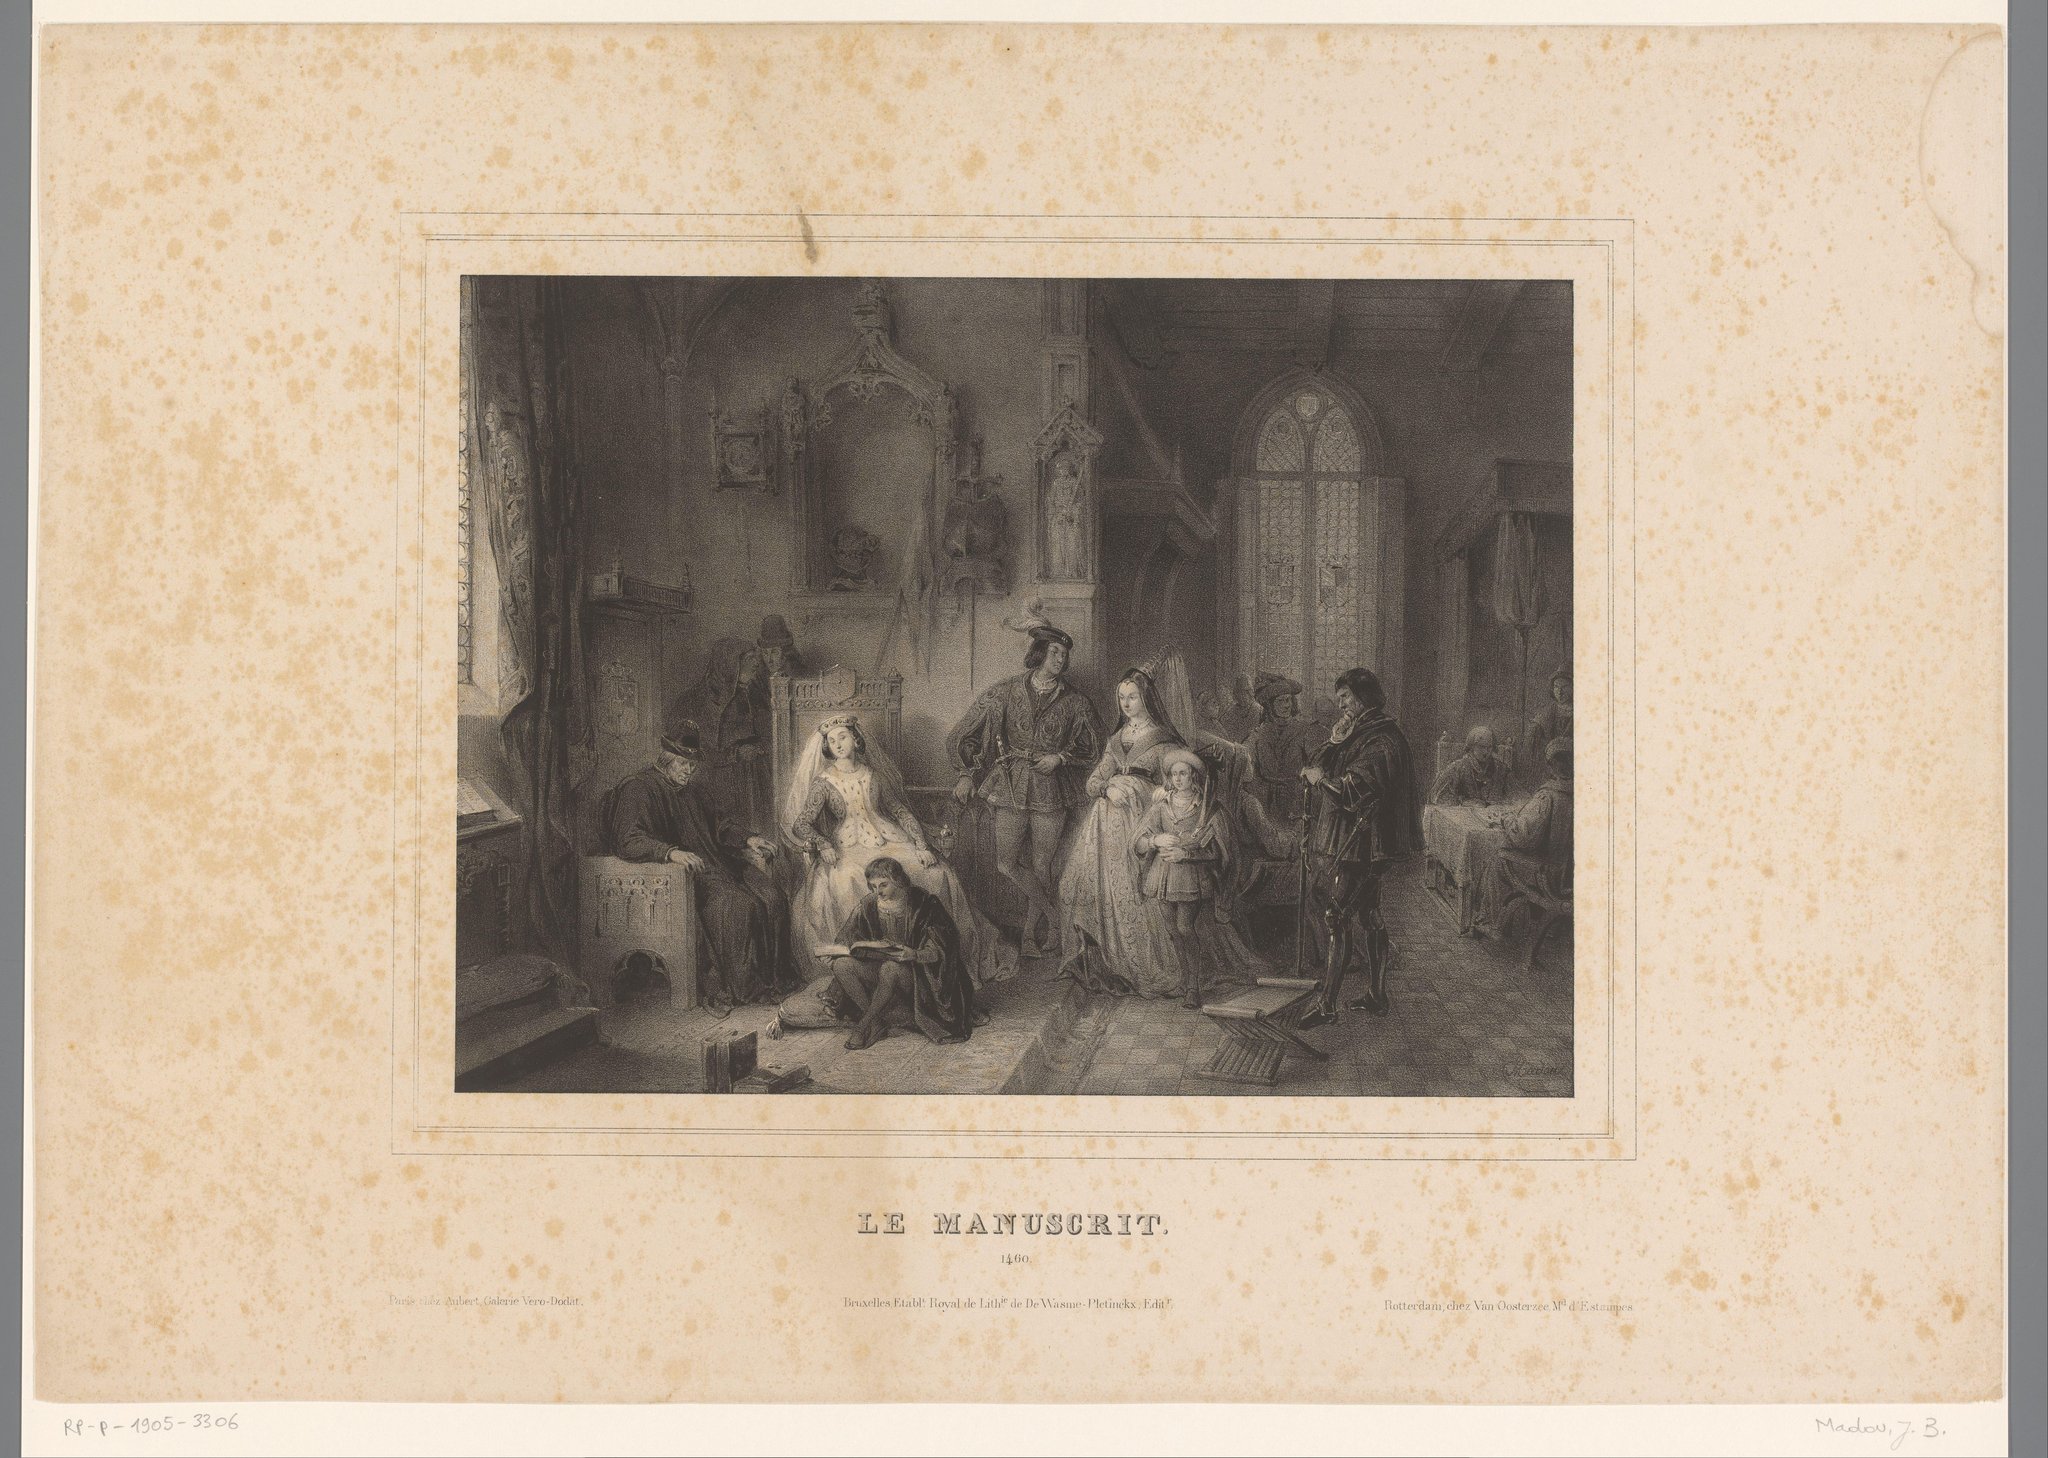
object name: print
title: Fysionomie van de welgestelden in Europa van de vijftiende tot en met de negentiende eeuw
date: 1835-1837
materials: paper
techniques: lithograph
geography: brussels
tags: reading, youth, adolescent, handwriting, written text, interior of the house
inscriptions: collector's mark: Lugt 2228